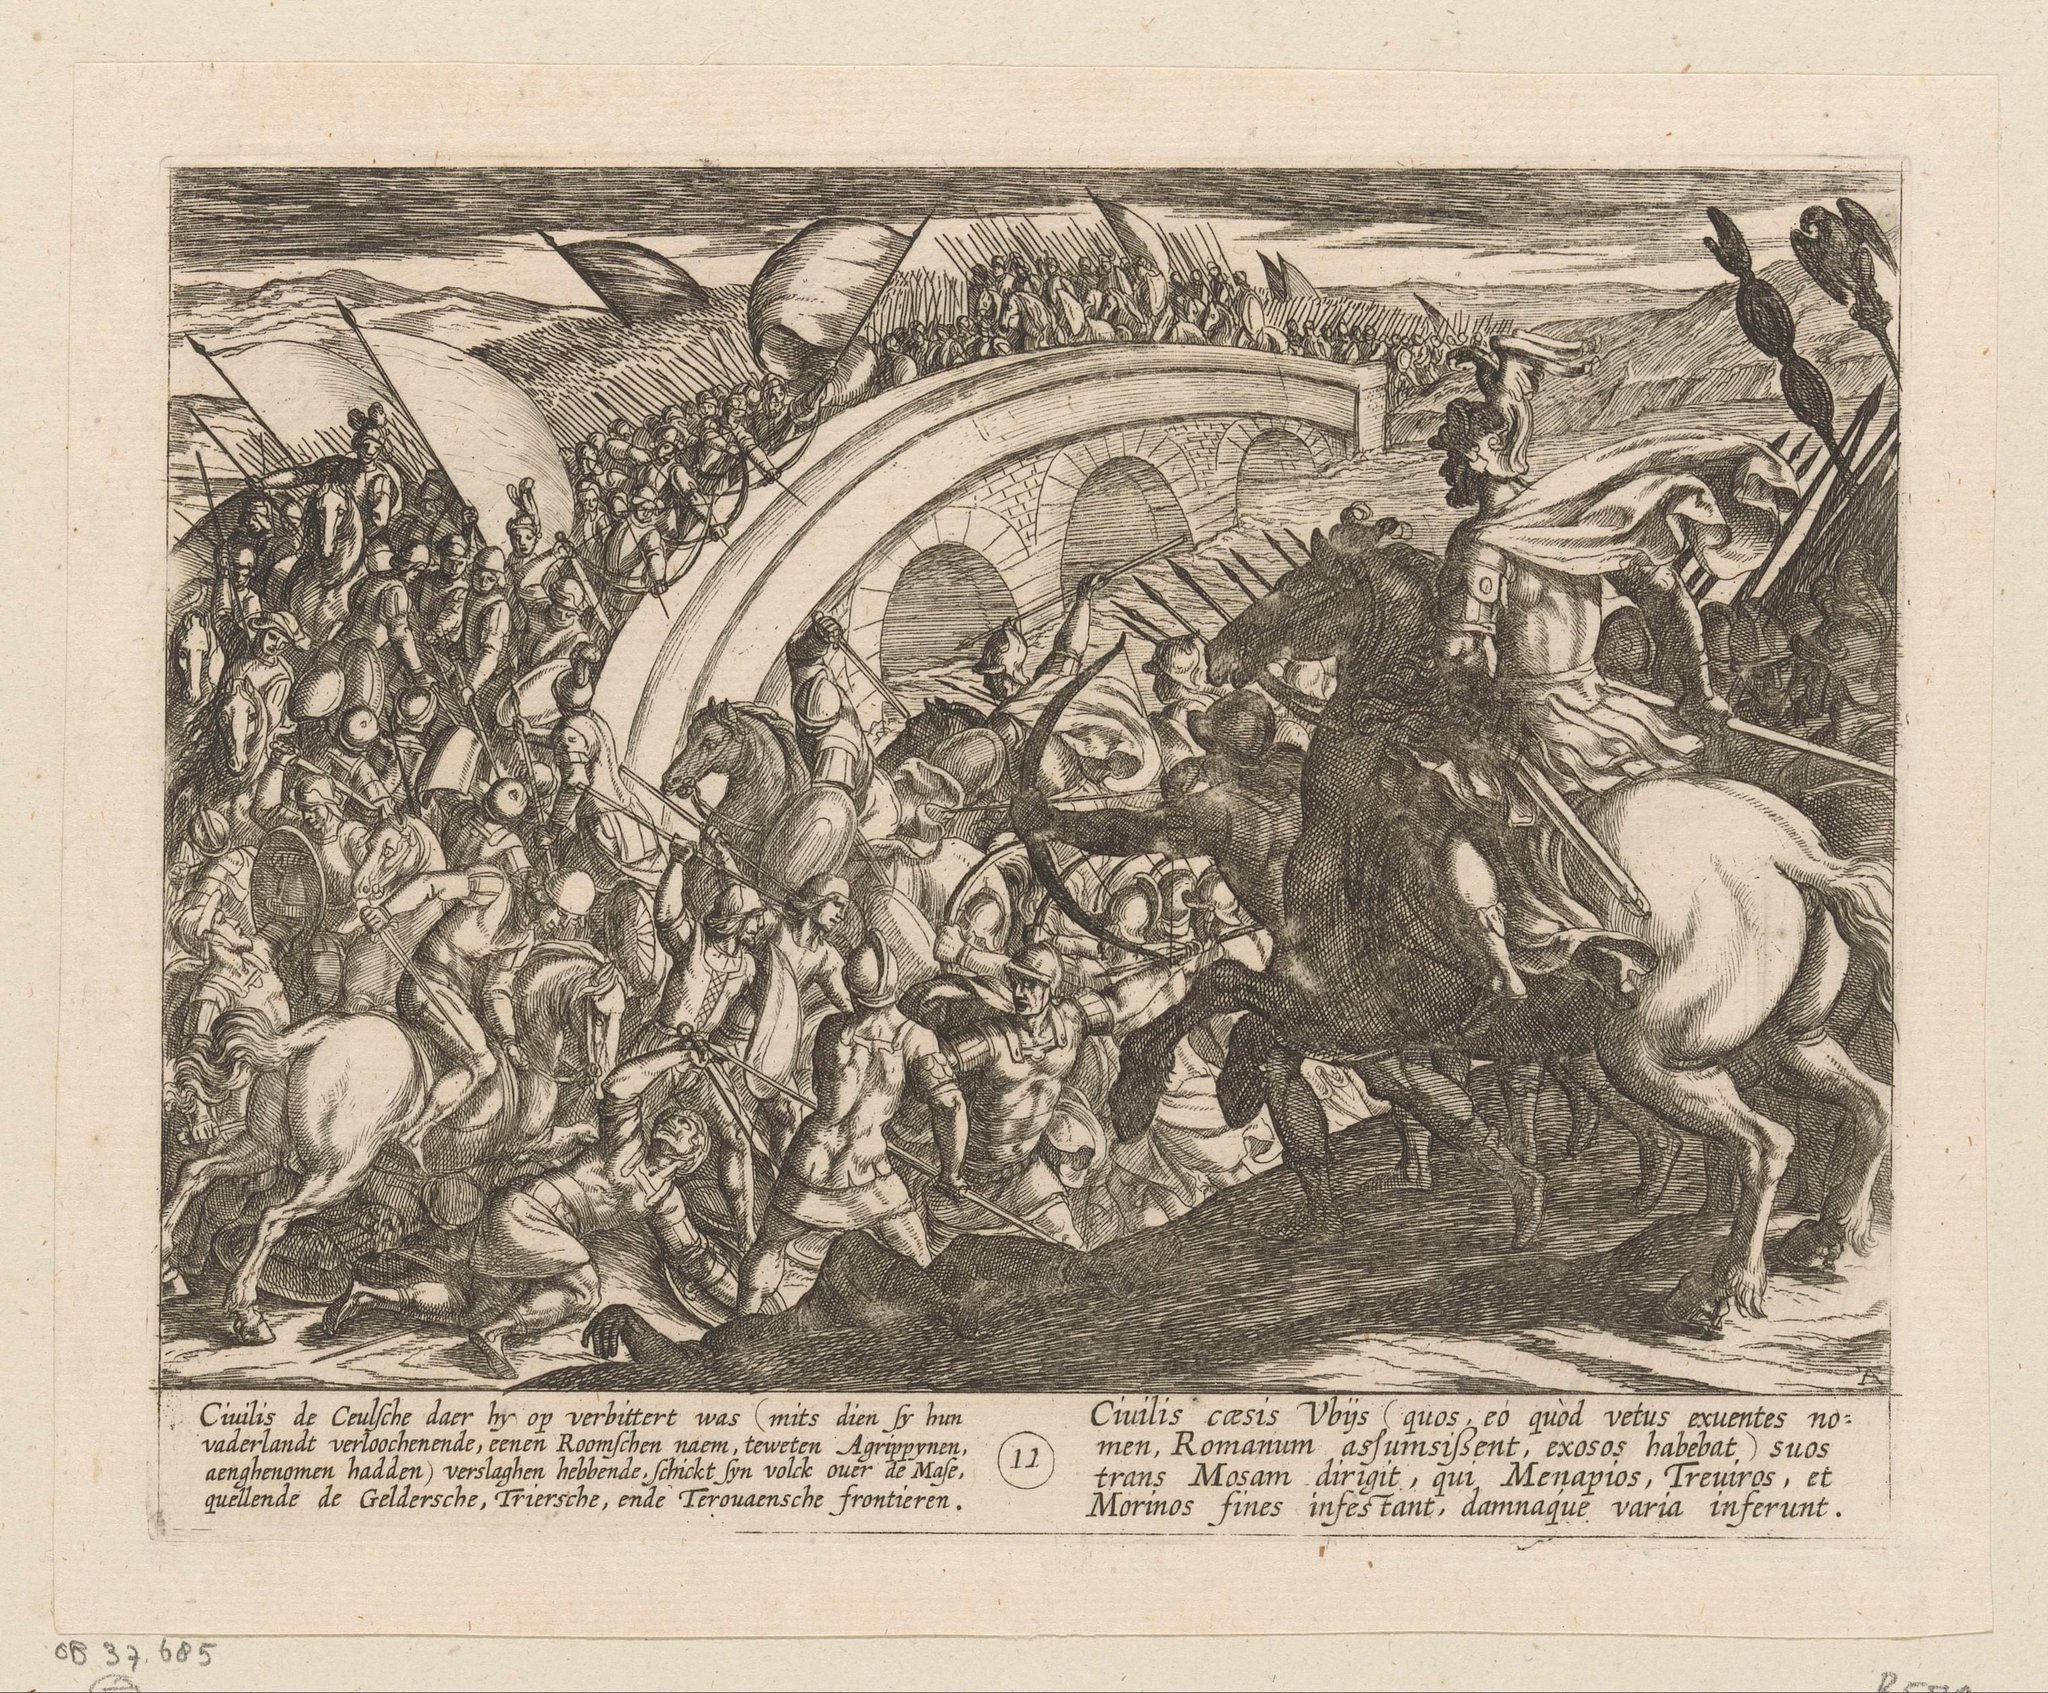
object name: history print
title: De Bataafse Opstand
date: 1612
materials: paper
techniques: etching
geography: italy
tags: battle, fighting in general, extinct, 'historical' peoples (with name)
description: De troepen van Civilis steken de Maas over. Prent nummer 11 in de serie prenten over de Bataafse Opstand: Batavorum cum Romanis bellum / à Corn. Tacito lib. IV & V. : Hist. olim descriptum, figuris nunc aeneis expressum, auctore Othone Vaenio Lugdunobatava = De Batavische oft oude Hollandtsche oorloghe teghen de Romeynen. Otto Vaenius, Antwerpen 1612. Onderaan twee verzen van vier regels in het Nederlands en in het Latijn. Zonder tekst op achterzijde.